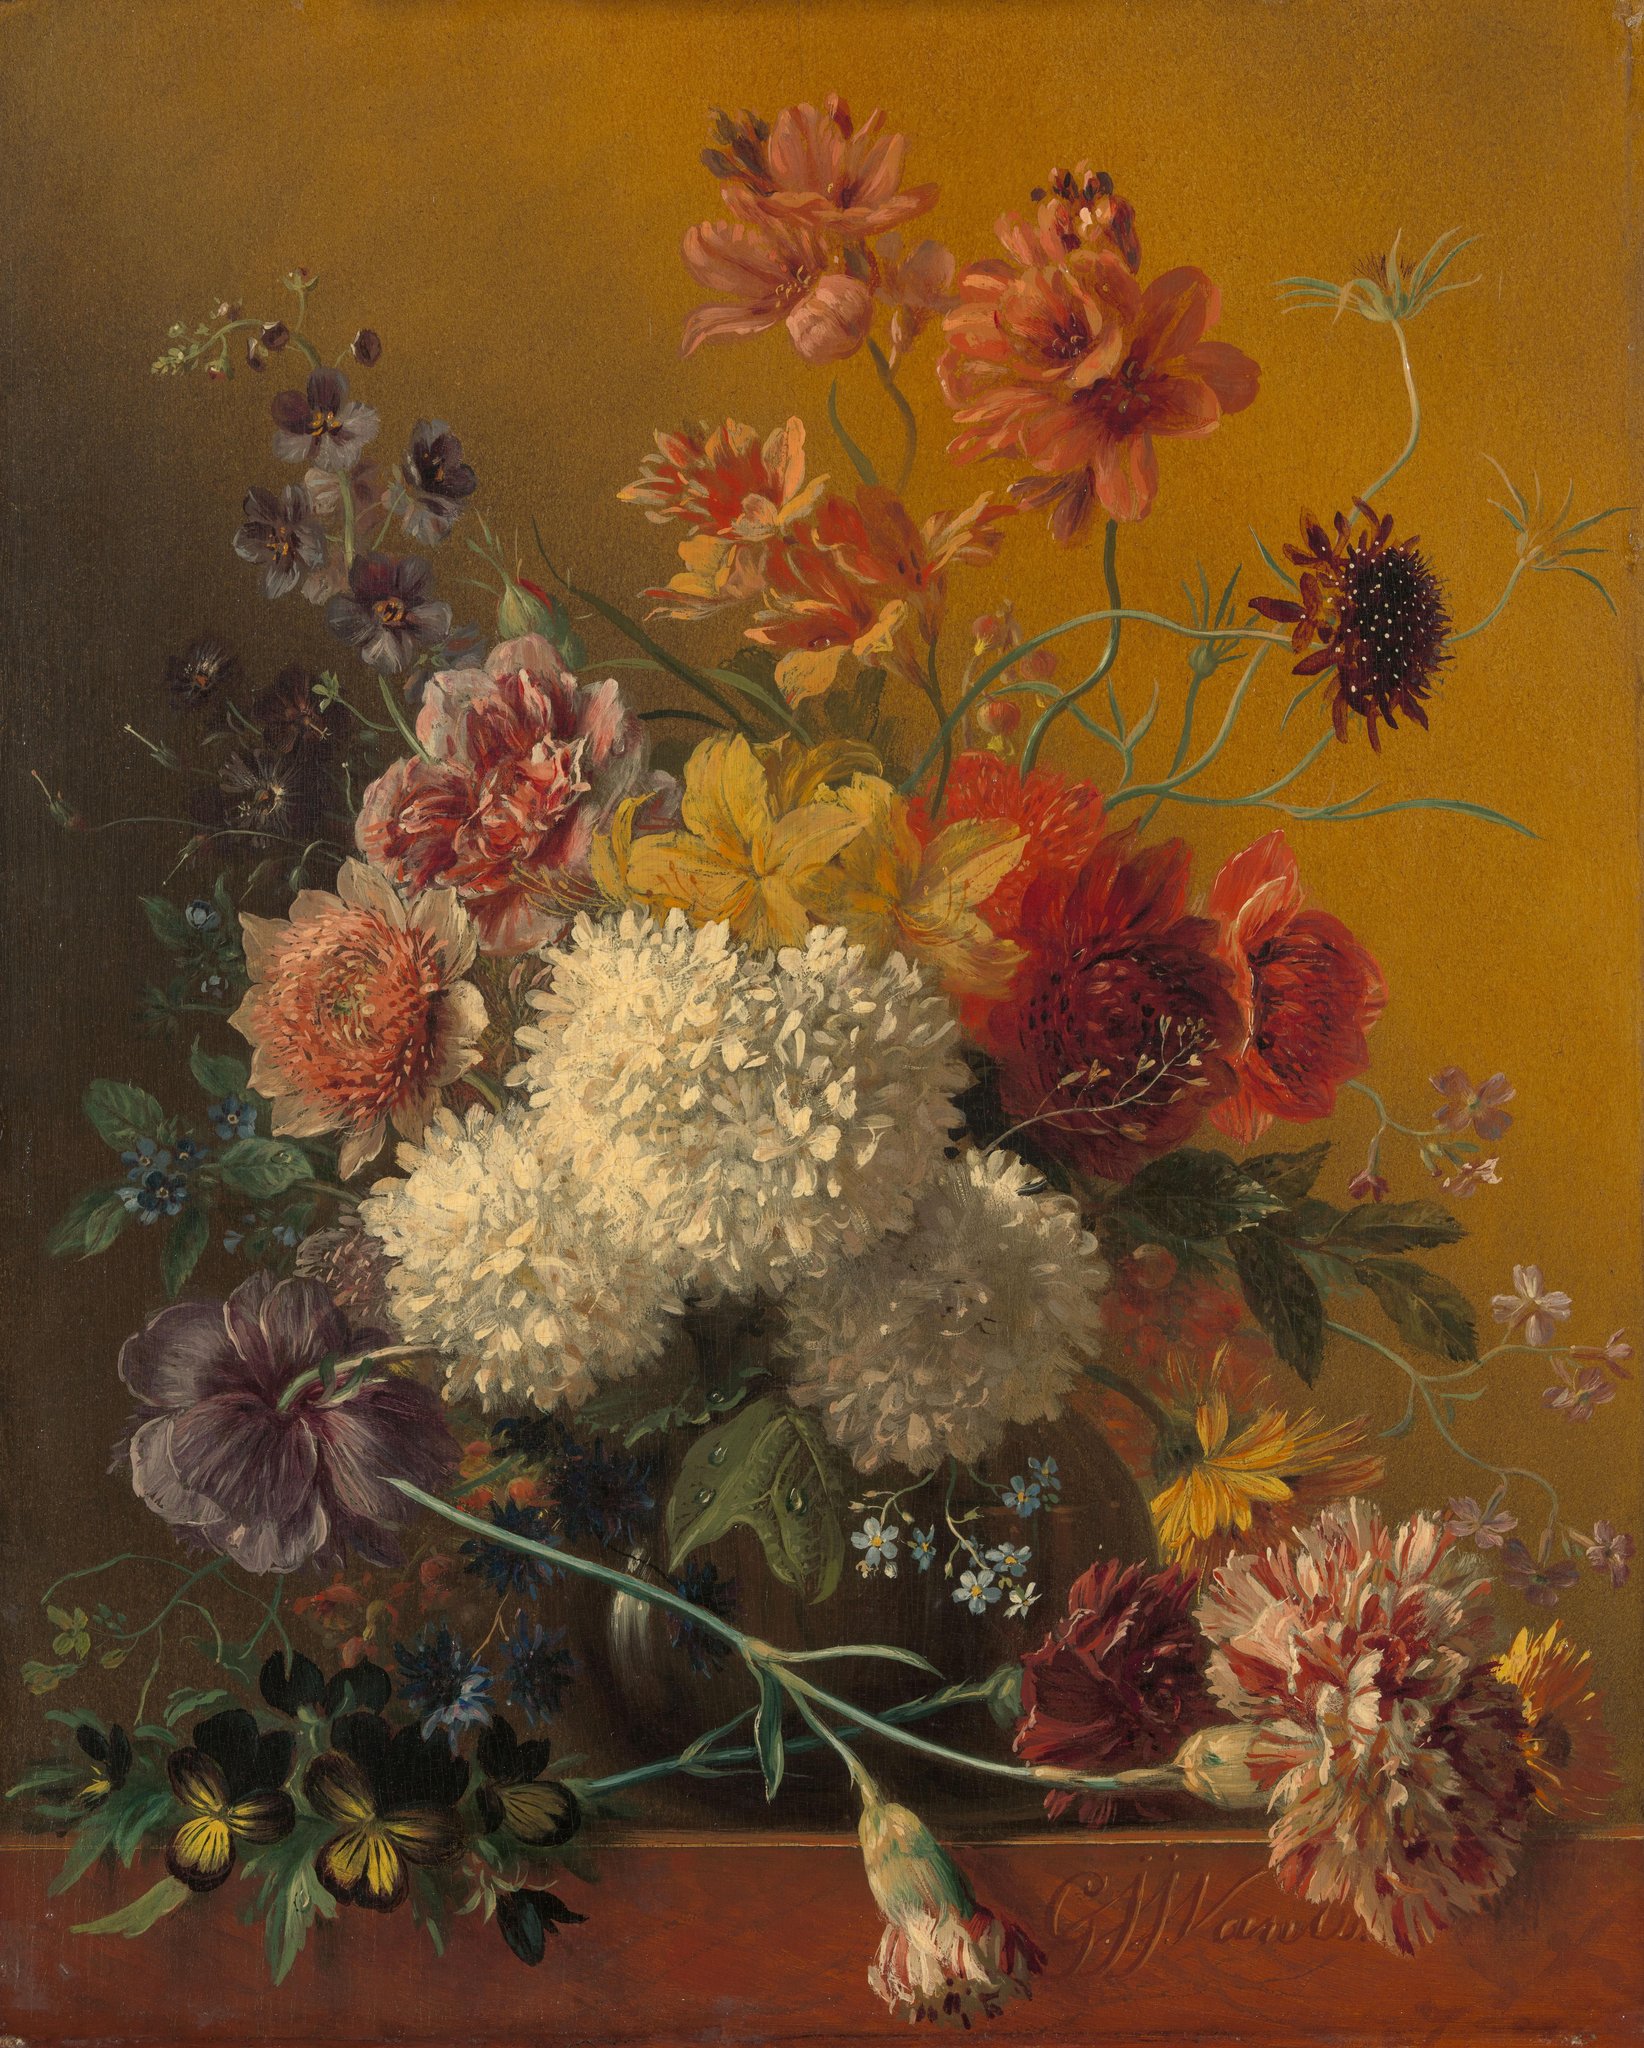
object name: painting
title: Still Life with Flowers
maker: georgius jacobus johannes van os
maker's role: draughtsman, painter, print maker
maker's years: 1782-1861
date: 1820-1861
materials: oil, panel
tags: still life of plants, flowers and fruit, flowers in a vase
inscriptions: signature: ‘G.J.J. Van Os’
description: Stilleven met bloemen. Op een plint staat een vaas met een boeket bloemen (anjers, viooltjes en dahlia's).